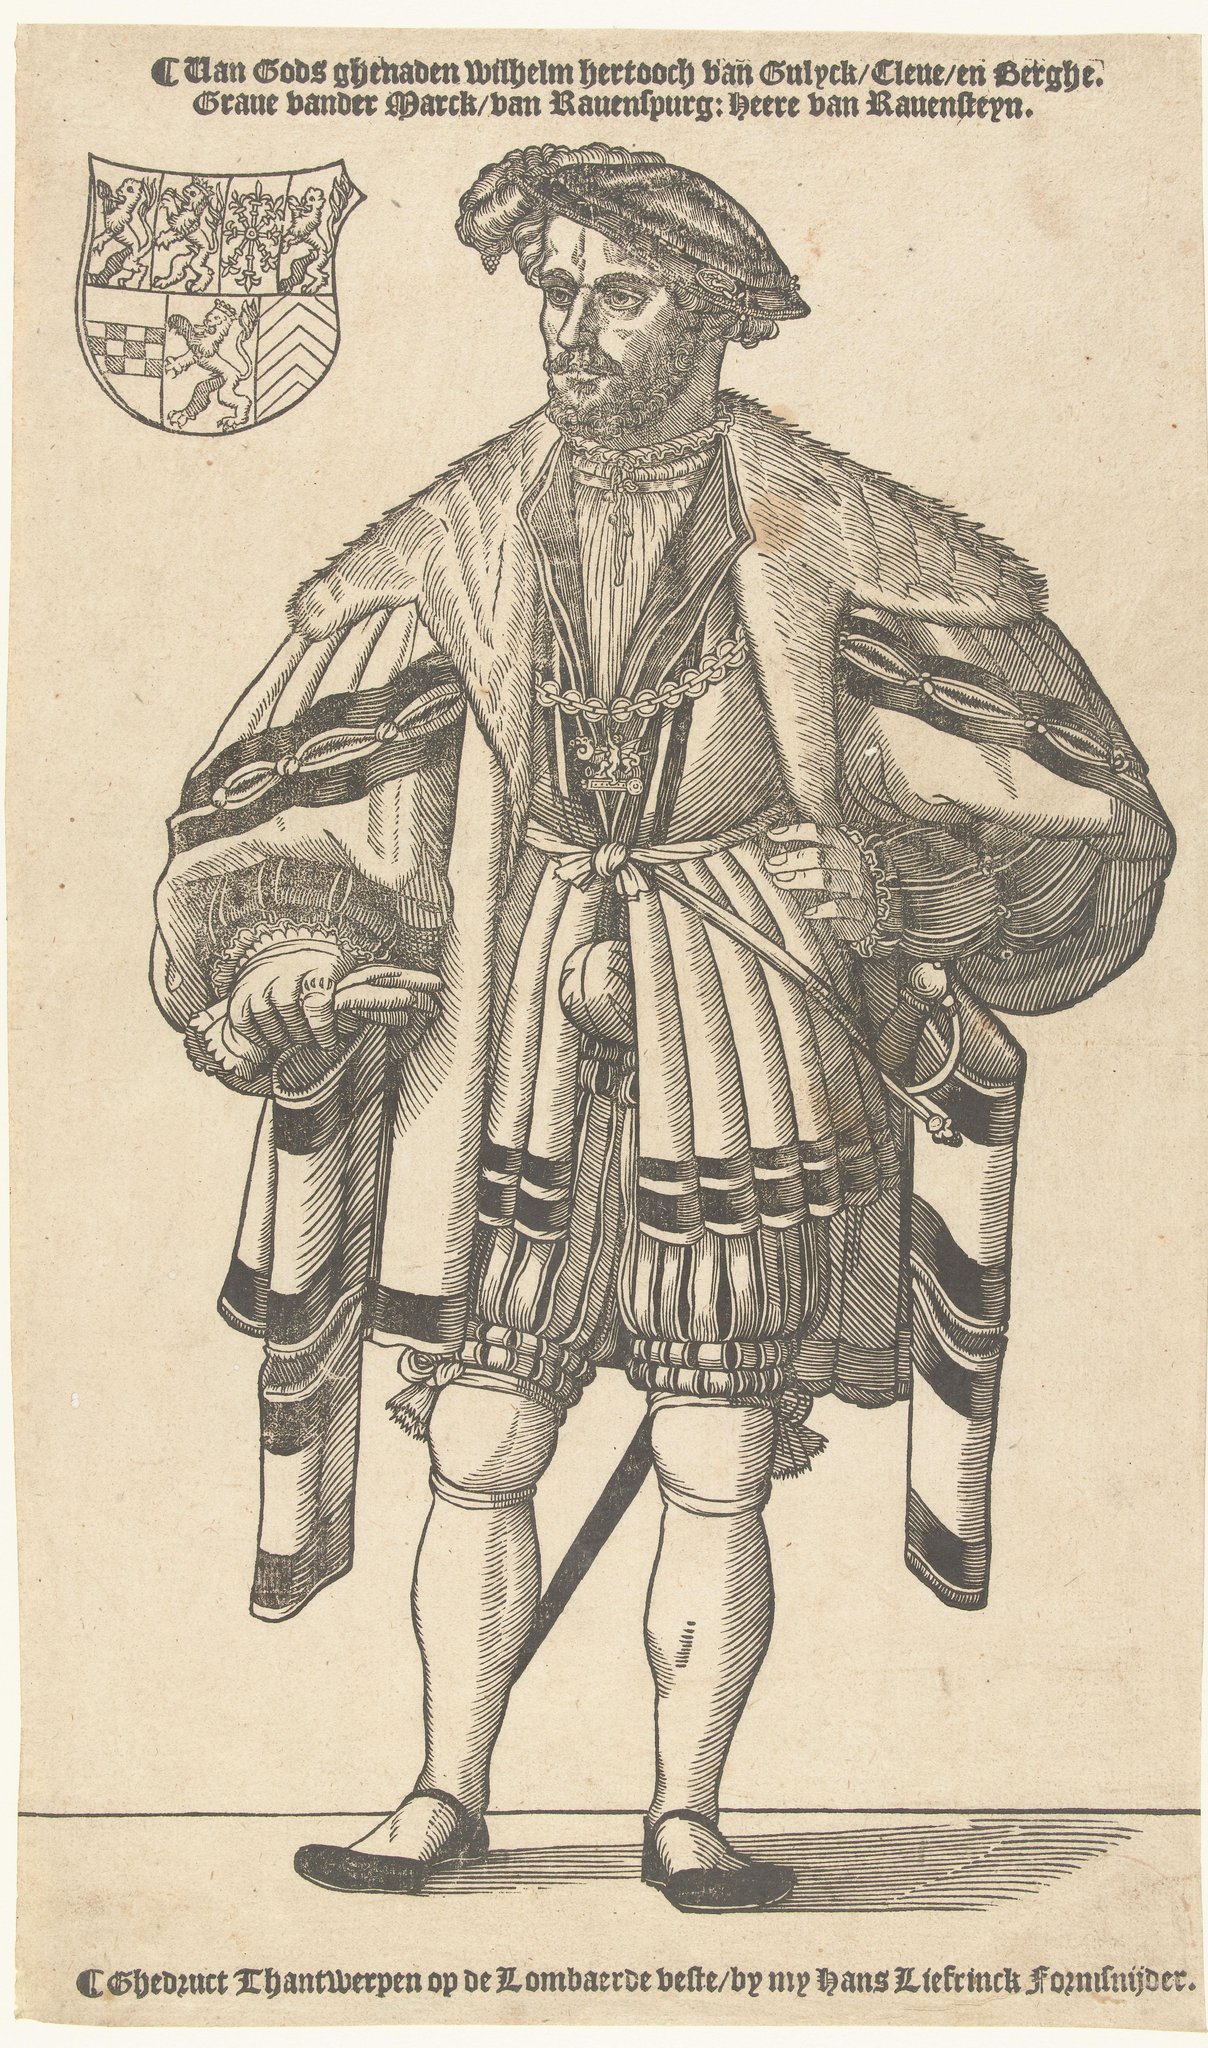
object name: print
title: Portret van hertog Willem van Kleef, Gulik en Berg, graaf van Mark, heer van Ravenstein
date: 1540-1573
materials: paper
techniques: woodcut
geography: antwerp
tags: hertog, willem ii (hertog van gelre)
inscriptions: collector's mark: Lugt 240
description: Portret ten voeten uit. In de rechterhand de handschoenen, de linkerhand in de zij.